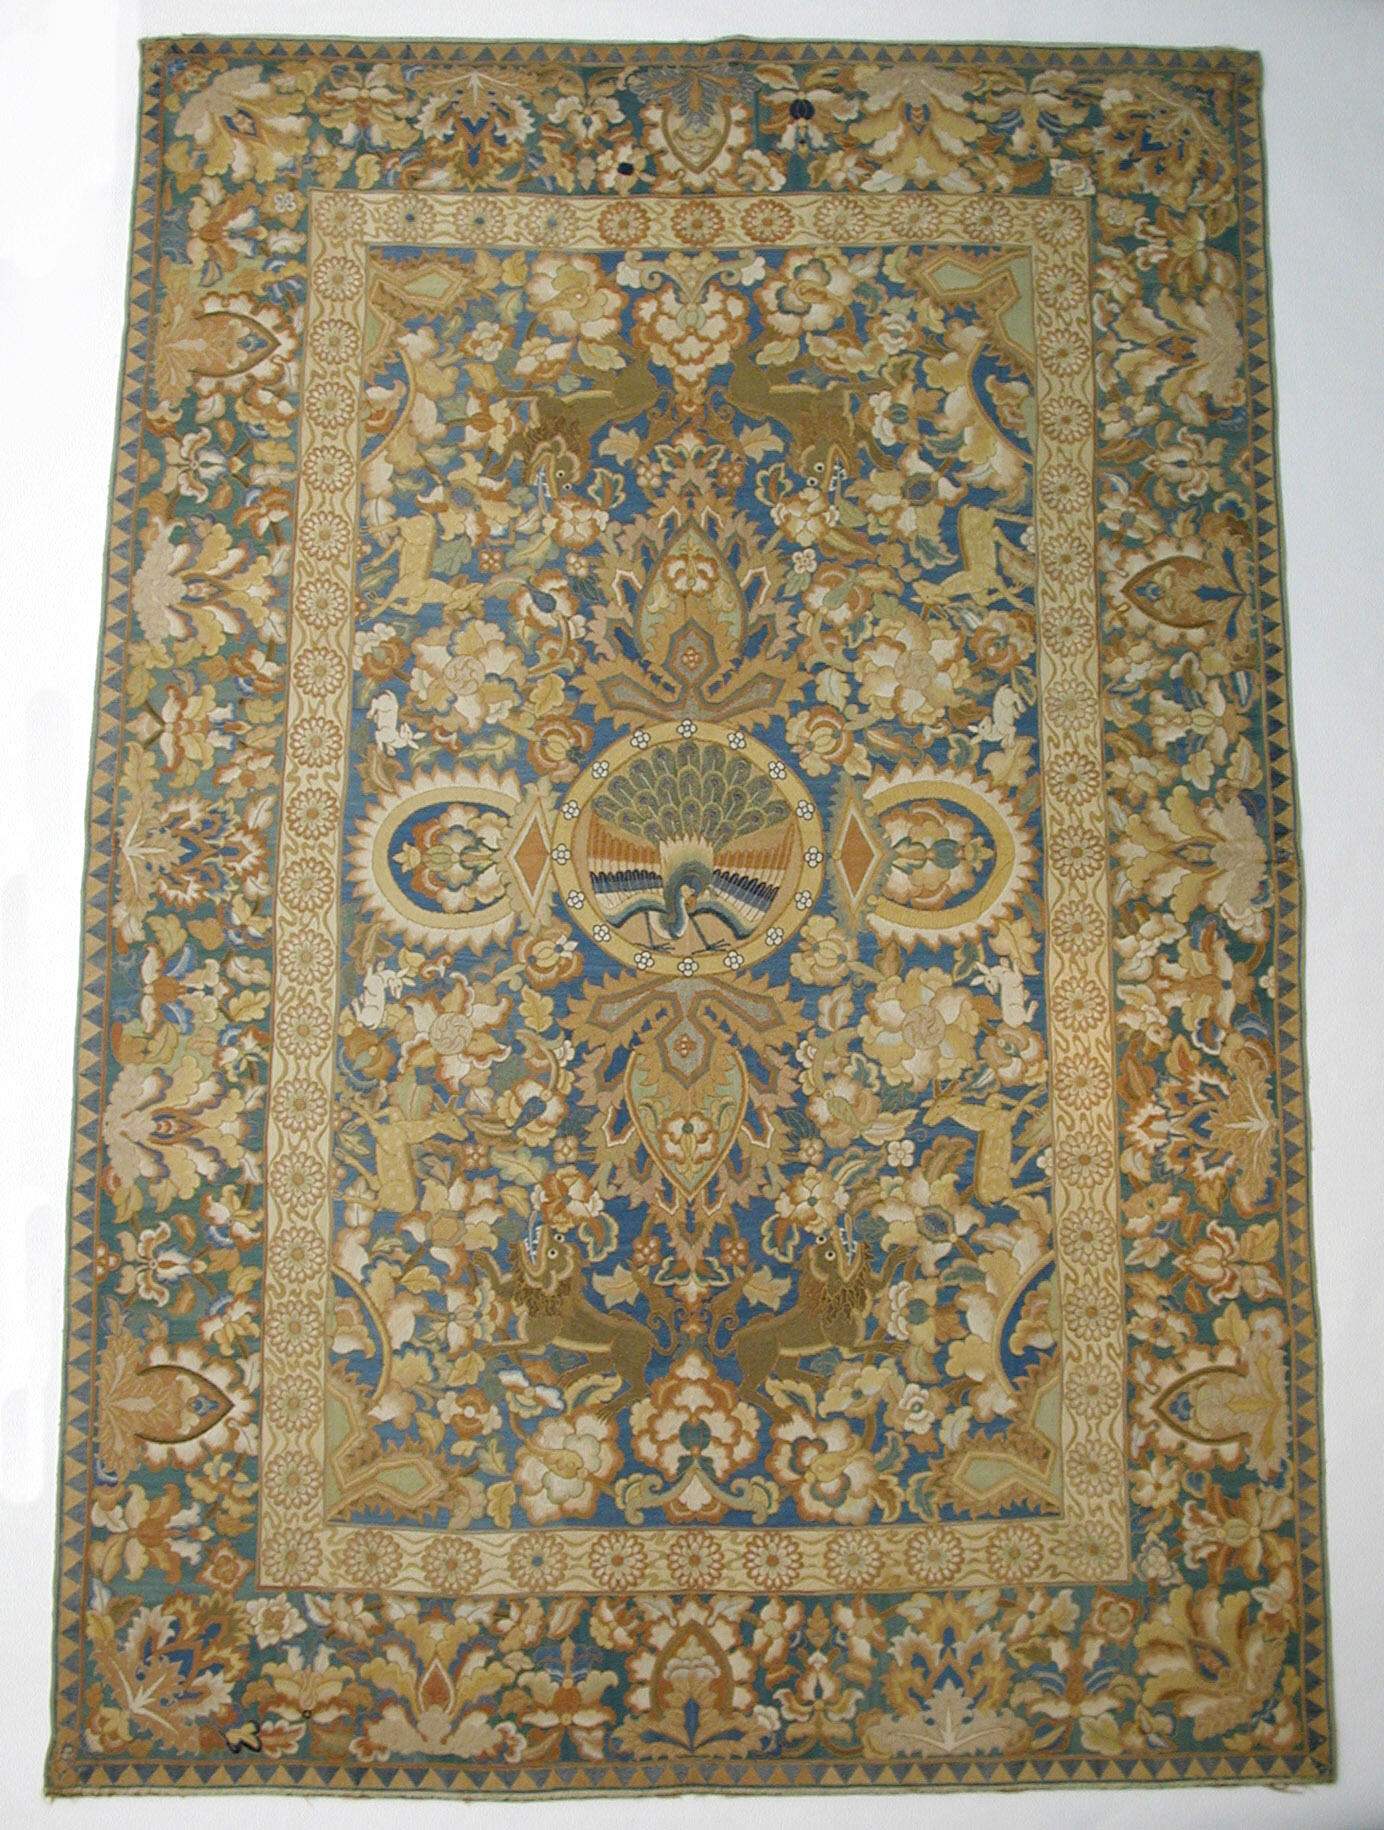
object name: cover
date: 1601-1700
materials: cotton, silk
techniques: embroidery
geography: india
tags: peacocks,deer,lions,rabbits